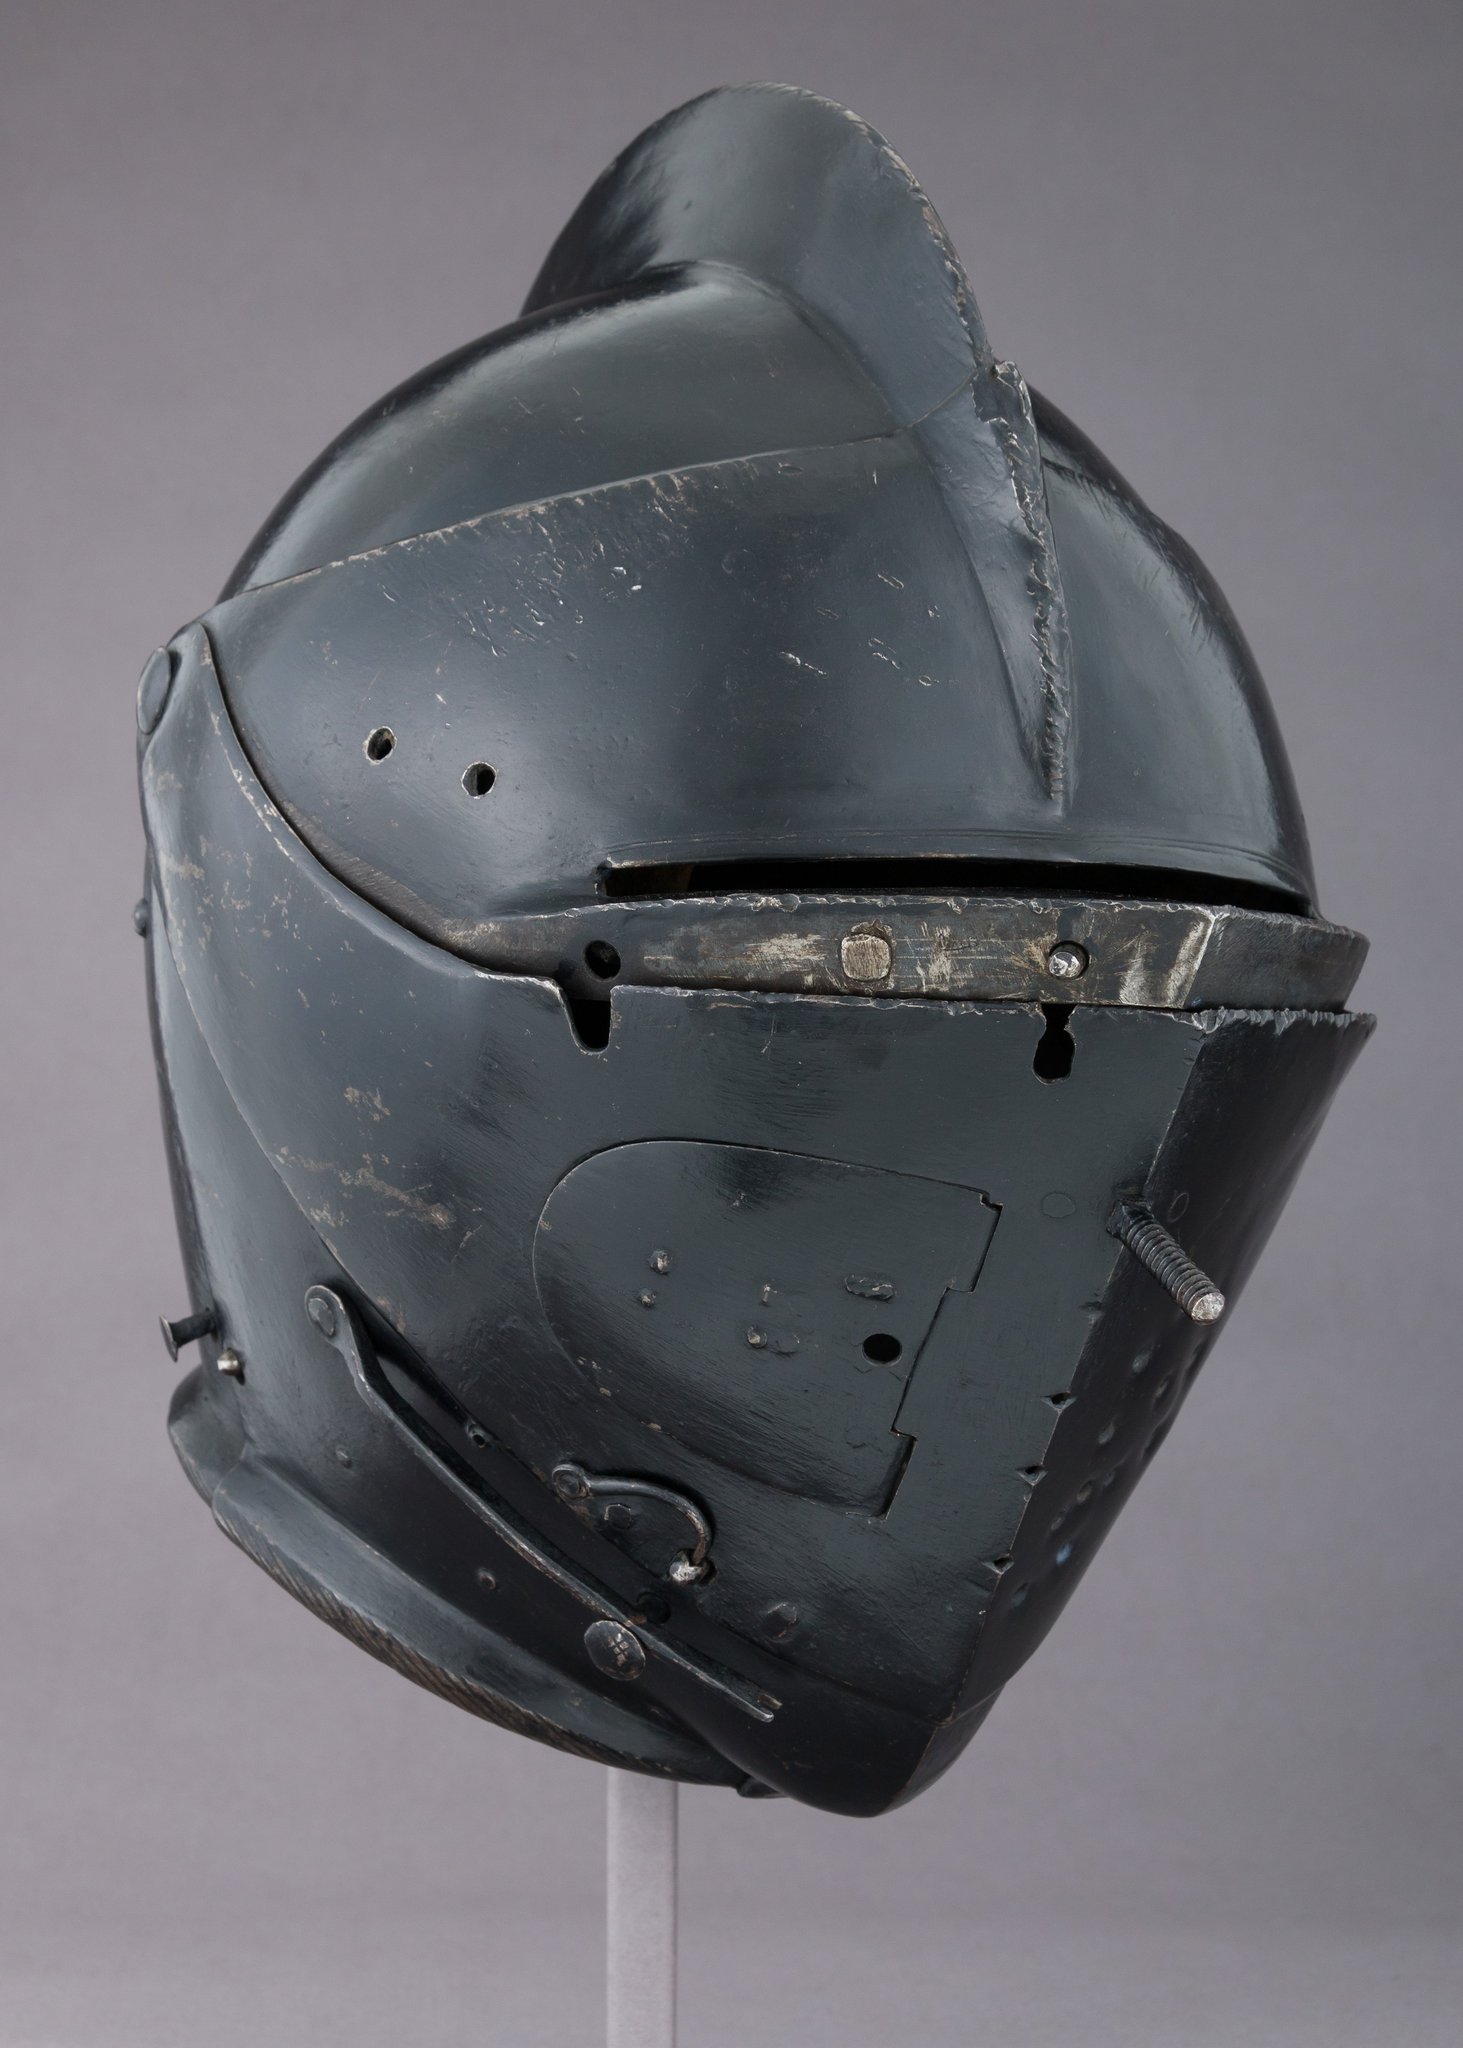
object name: close helmet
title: Close Helmet for the Tournament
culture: german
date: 1575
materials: steel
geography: germany